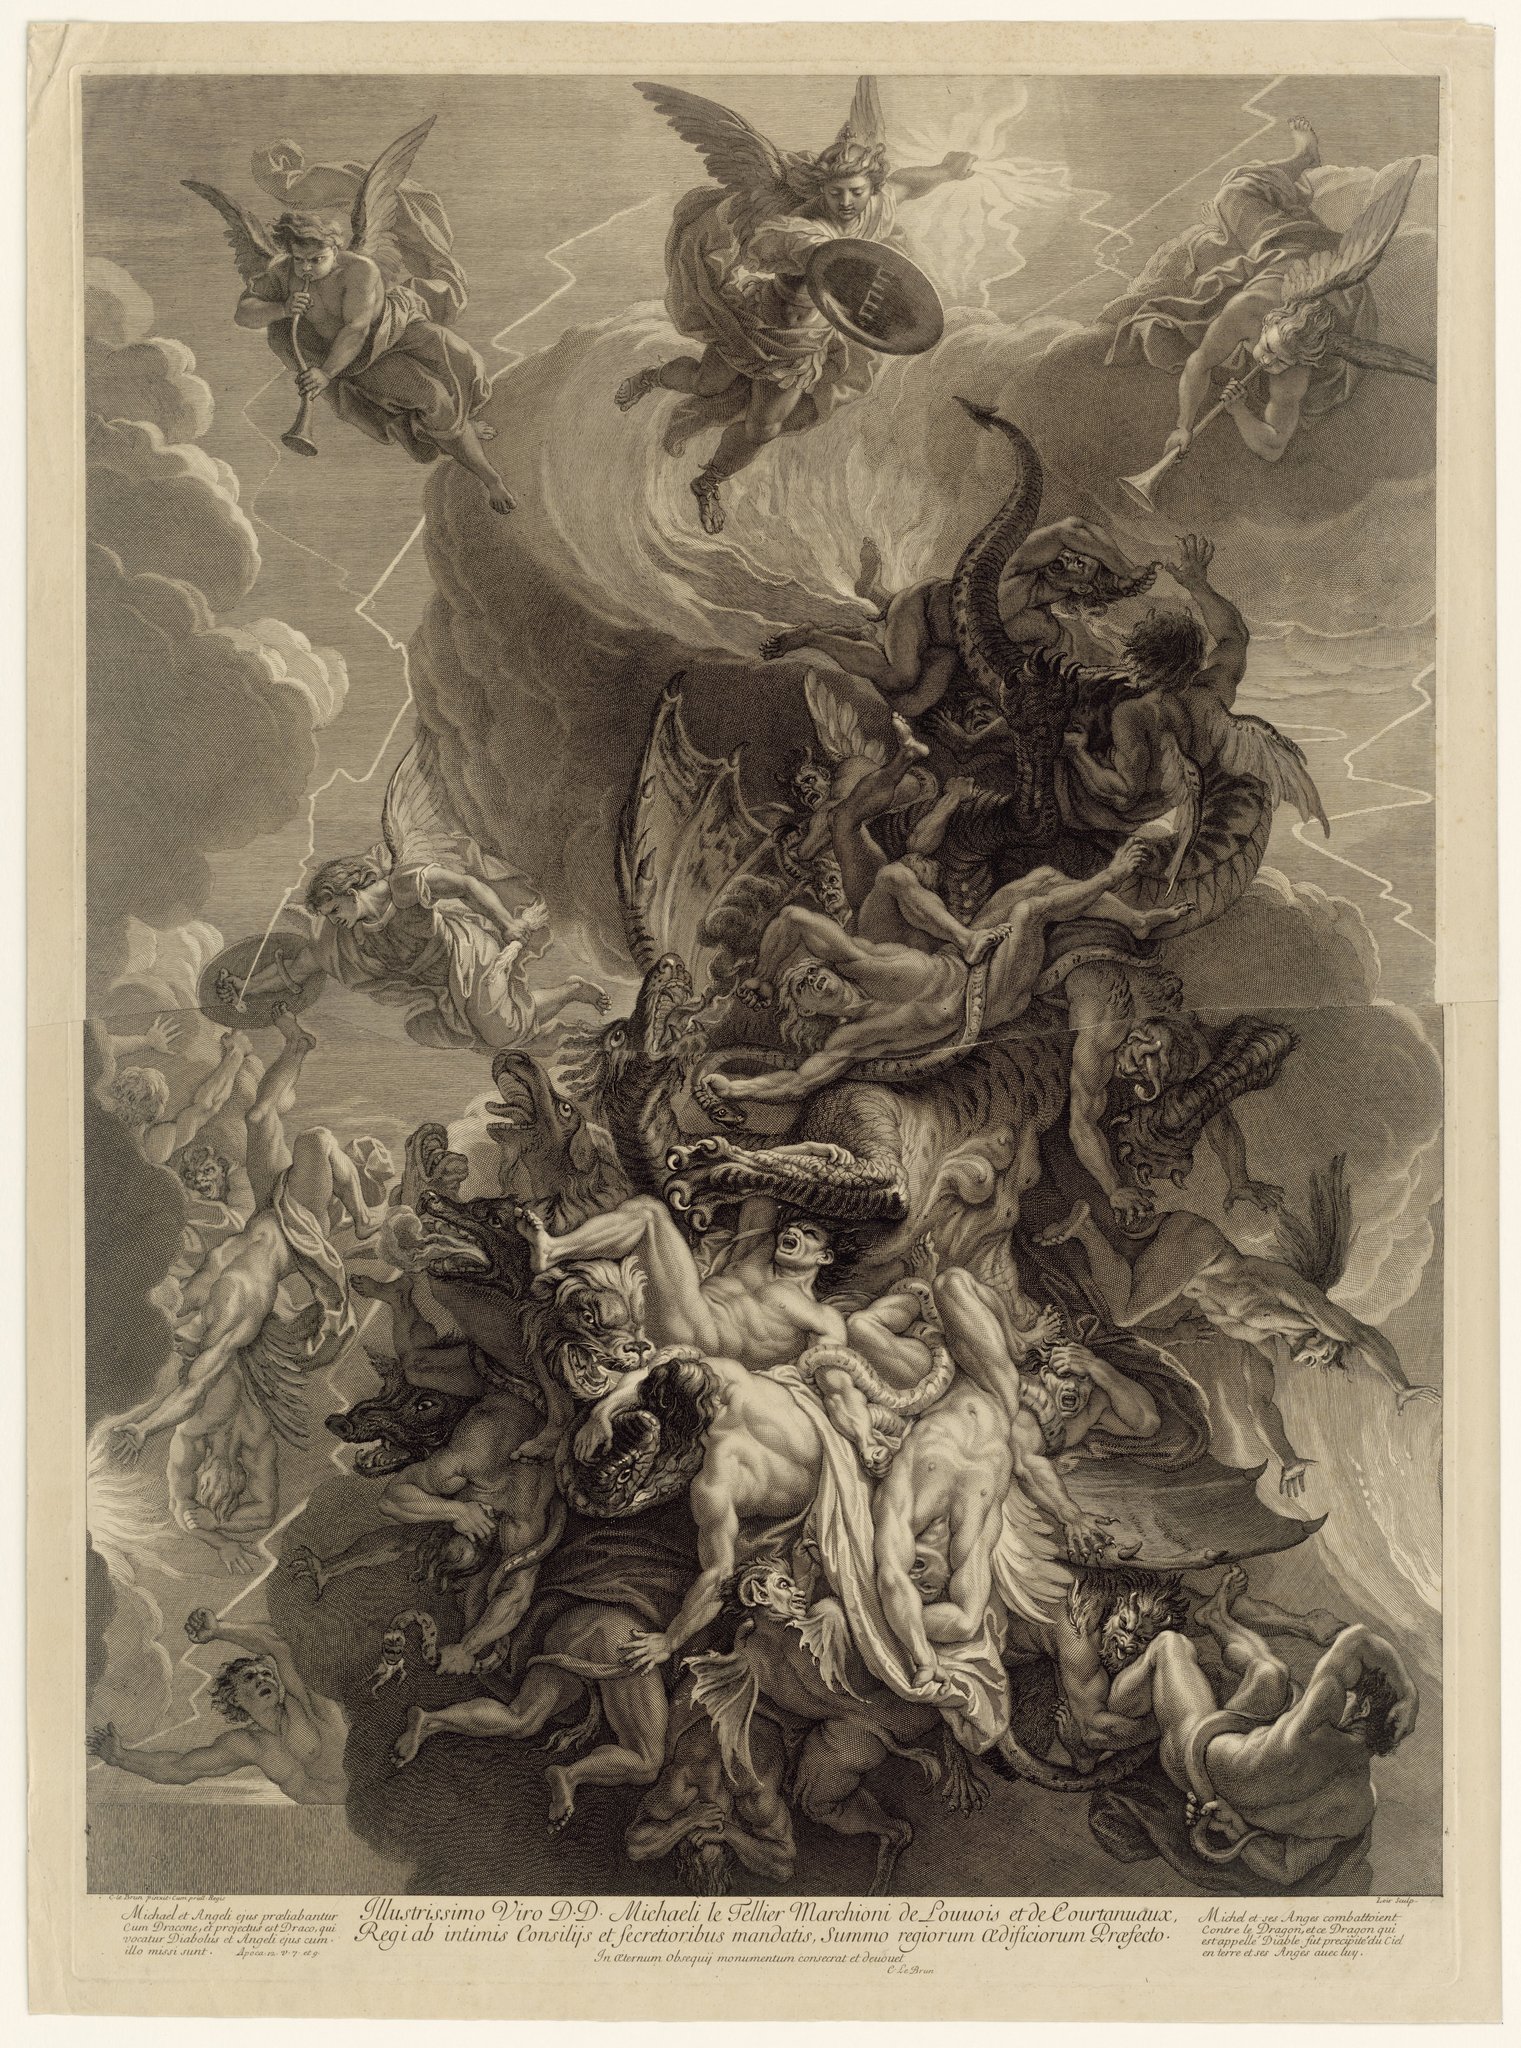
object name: print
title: De val der opstandige engelen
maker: alexis loir (i)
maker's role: print maker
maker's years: 1640-1713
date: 1650-1713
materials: paper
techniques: engraving, etching